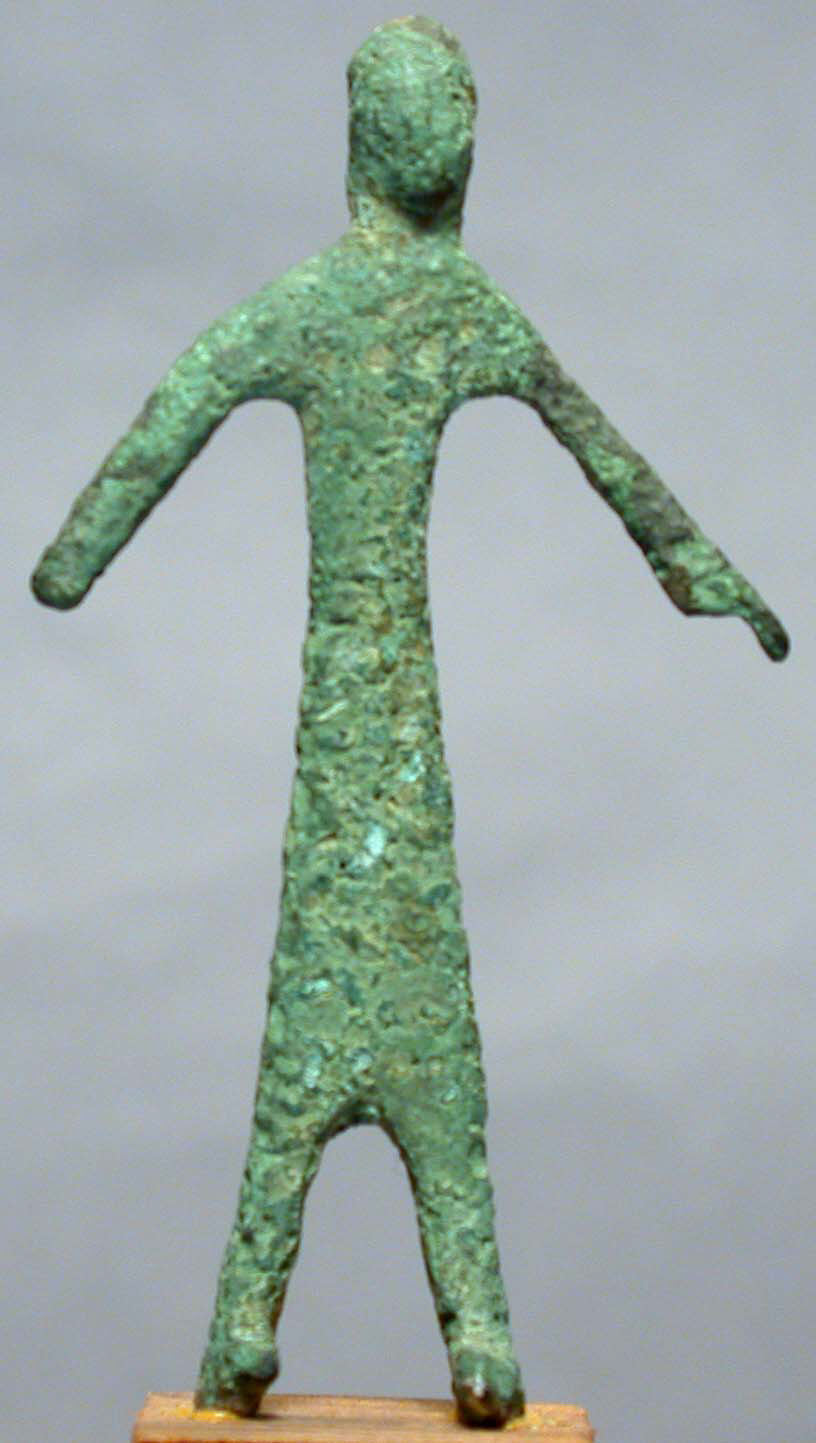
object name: statuette of man with extended arm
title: Bronze statuette of man with extended arms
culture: etruscan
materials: bronze